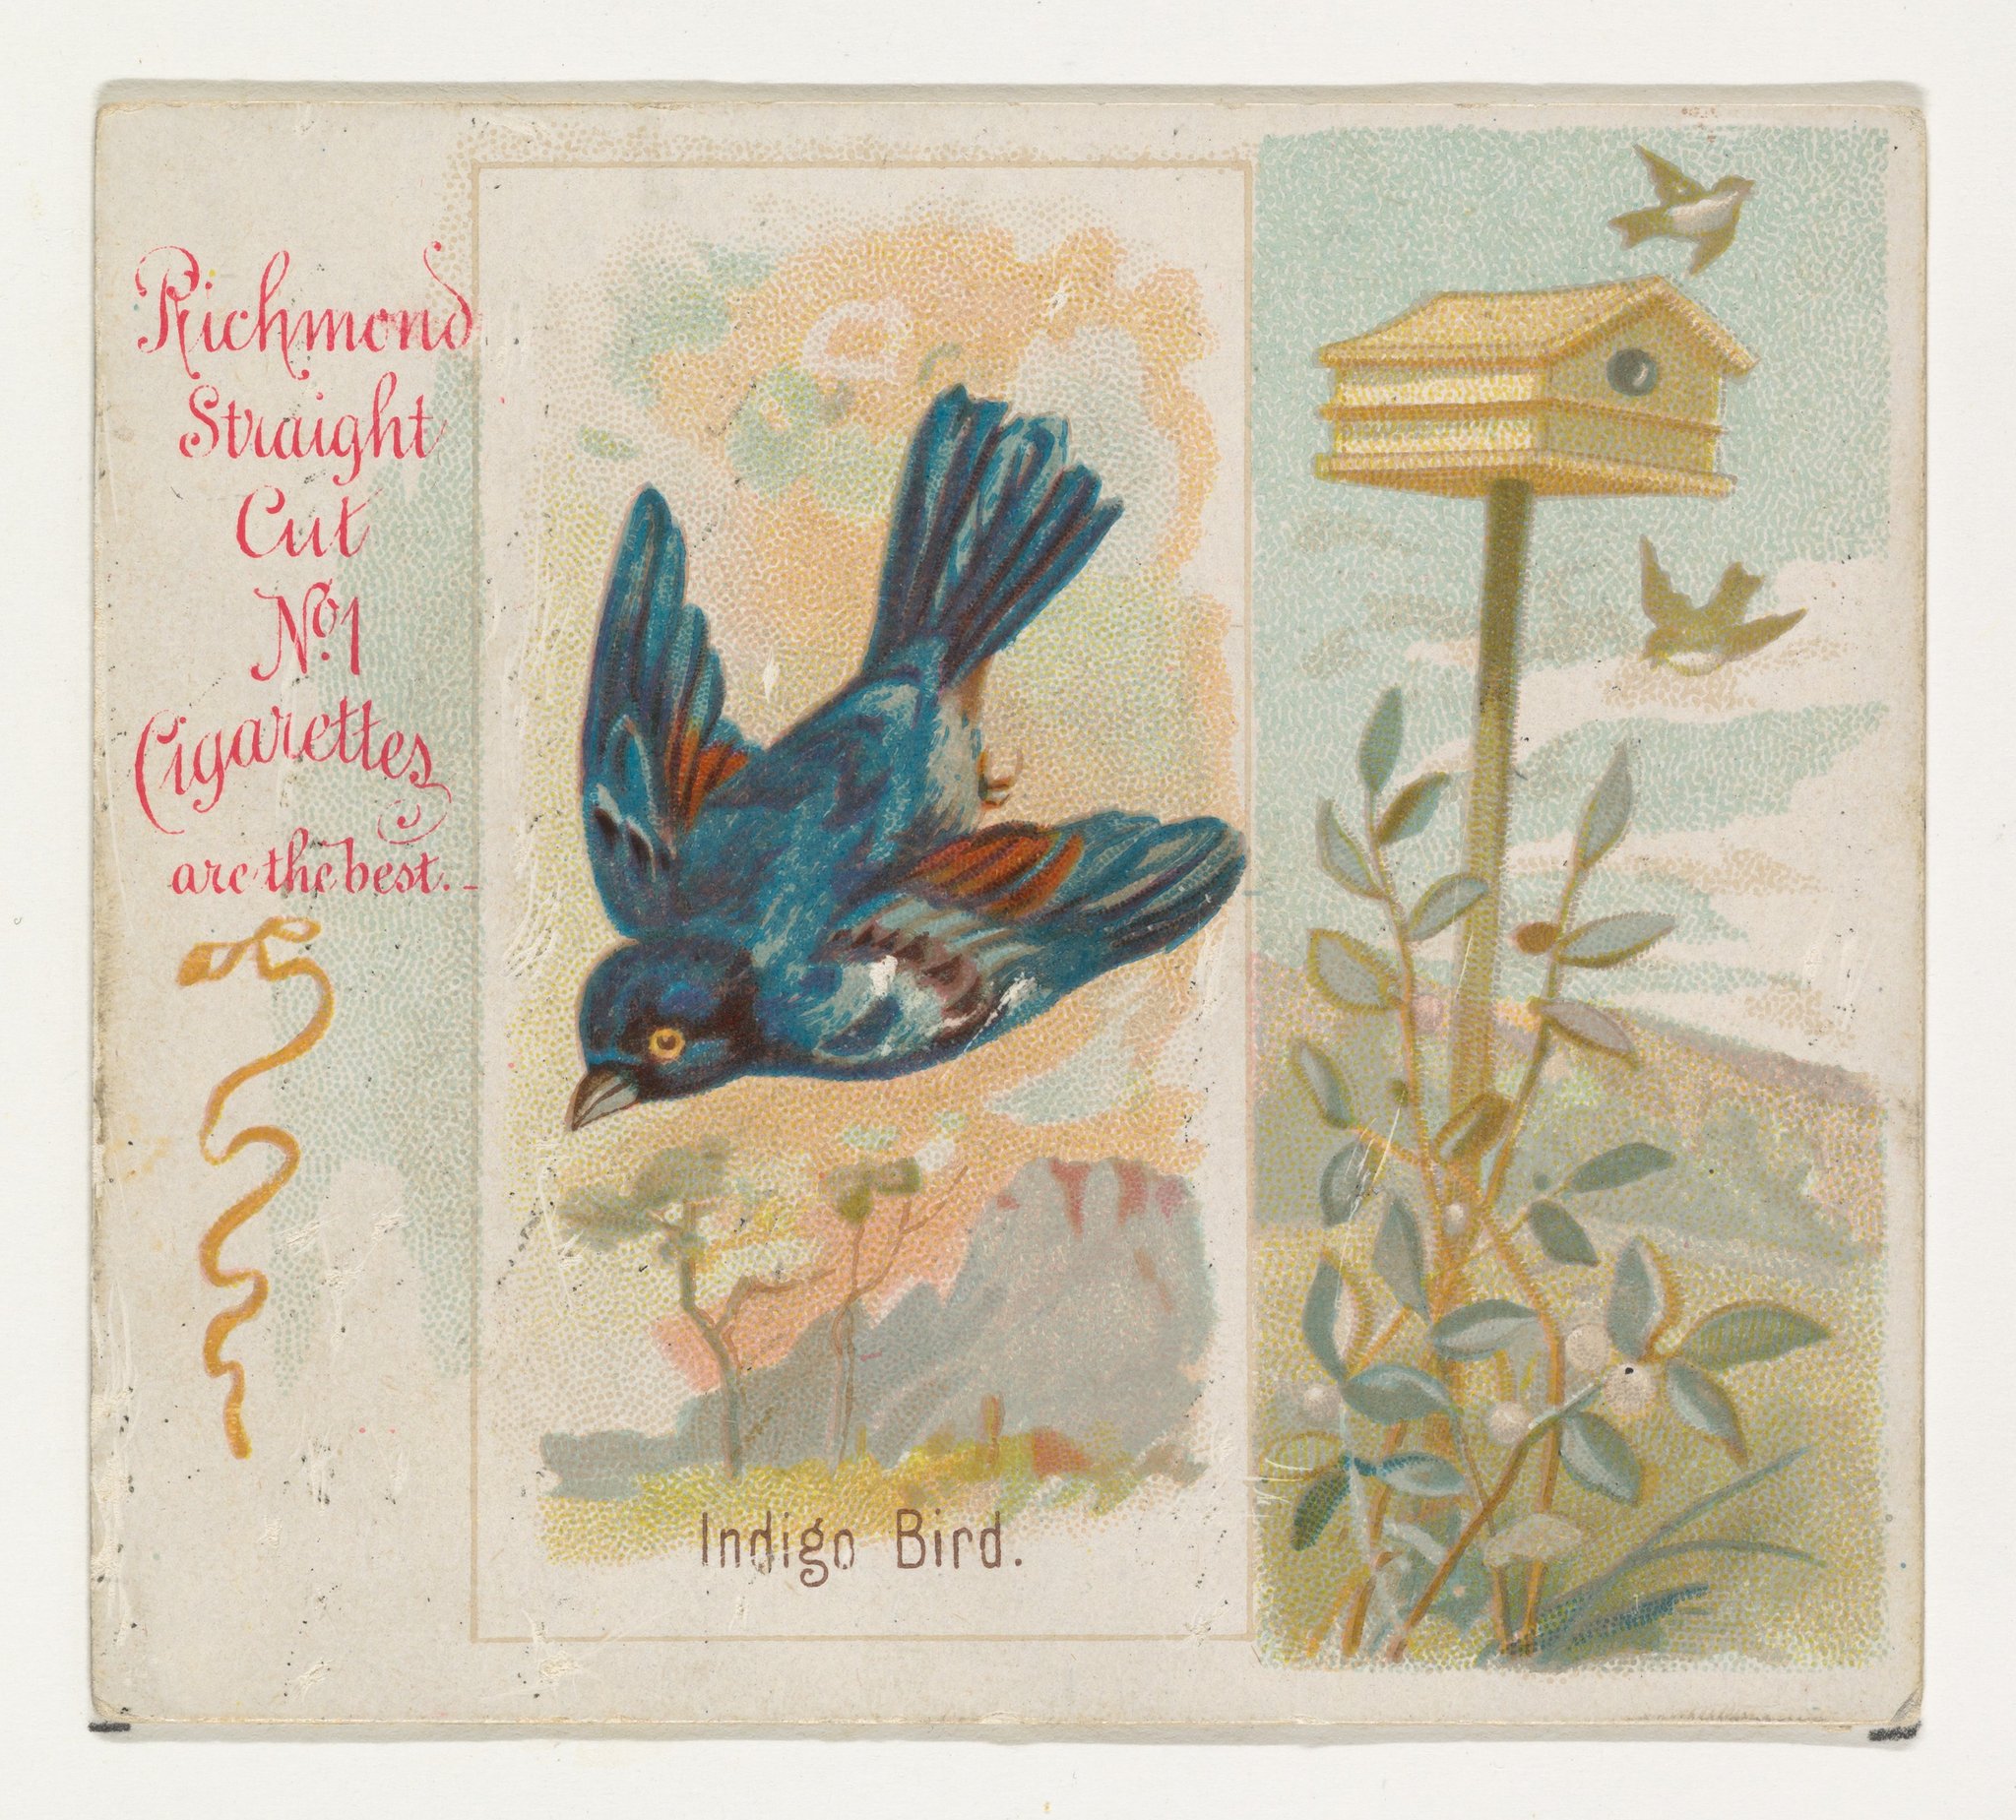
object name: print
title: Indigo Bird, from the Song Birds of the World series (N42) for Allen & Ginter Cigarettes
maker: allen & ginter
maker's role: publisher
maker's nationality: american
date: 1890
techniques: color lithograph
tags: birds